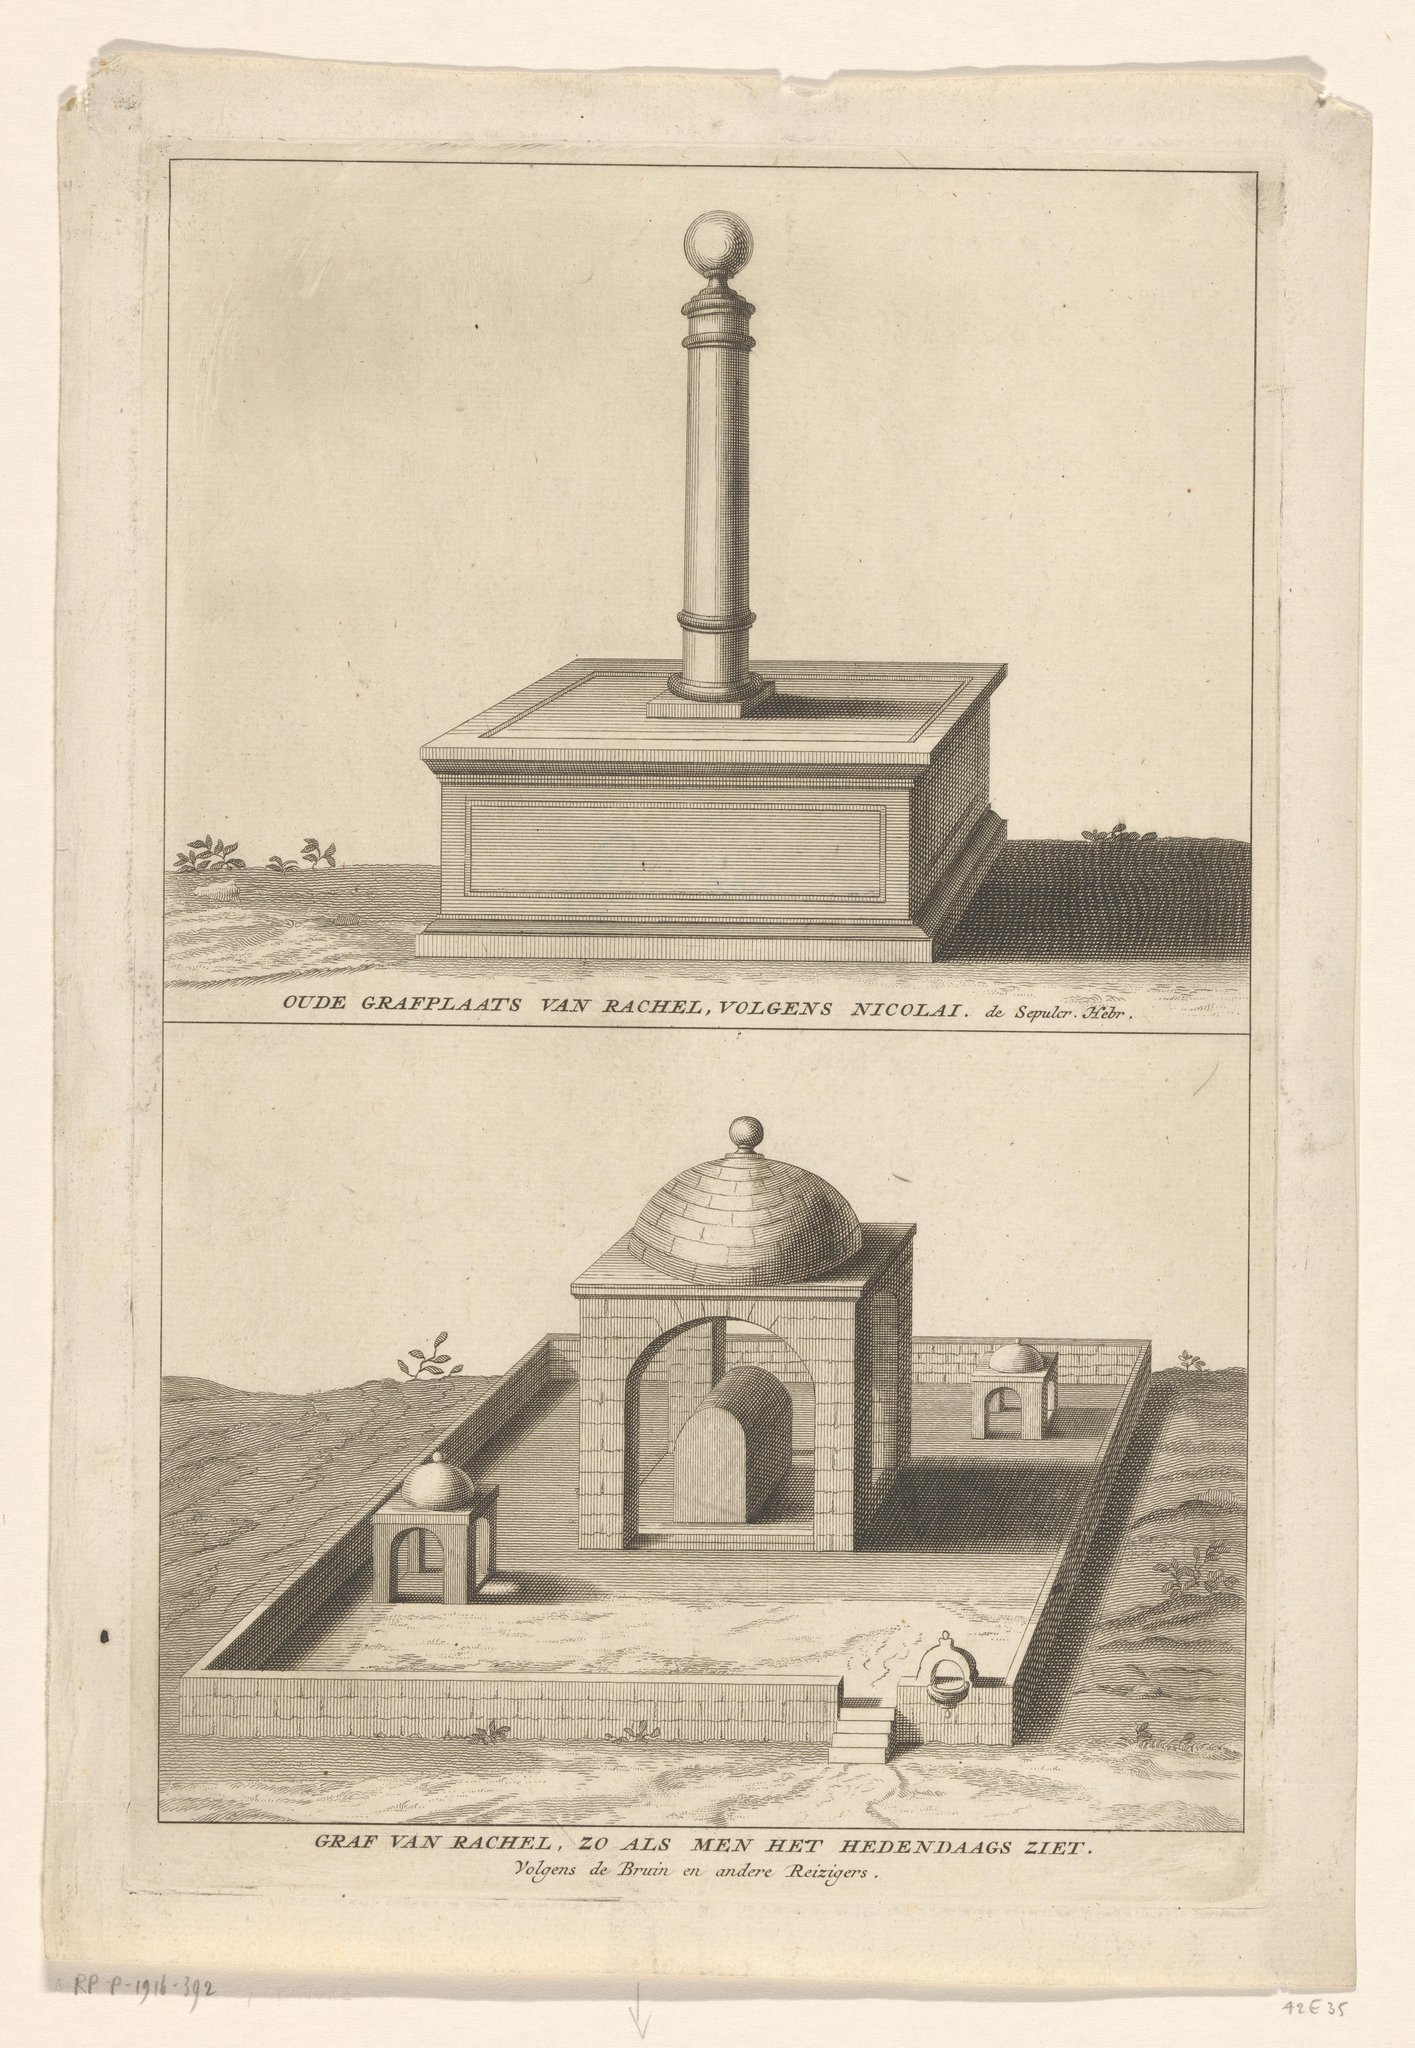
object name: book illustration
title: Oude grafplaats van Rachel, volgens Nicolai. de Sepuler. Hebr. / Graf van Rachel, zo als men het hedendaags ziet. Volgens de Bruin en andere Reizigers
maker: Anonymous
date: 1727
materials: paper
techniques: engraving, etching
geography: netherlands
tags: historical grave forms, female persons from the old testament (not in biblical context), grave-building, monumental tomb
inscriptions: collector's mark: Lugt 2228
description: Gebruikt als illustratie in: Het algemeen groot historisch, oordeelkundig, chronologisch, geografisch, en letterlyk naam- en woord-boek, van den gantschen H. Bijbel. Dienende tot de gedenk-stukken der Jooden en andere oudheden, ter opheldering der H. Schrift . Nu in't Nederduitsch overgezet, merkelyk vermeerdert, en met aanmerkingen verrykt, door Mattheus Gargon.' and it's additons: 'Byvogzel tot het algemeen groot . Naam- en woord-boek . En nu in zuiver Nederduitsch overgezet, merkelyk vermeerdert, en metv aanmerkingen verrykt, door Jakob van Ostade en Arn. Henr. Westerhovius.', by Augustines Calmet, published in Leiden, Amsterdam, by Samuel Luchtmans, R. & J. Wetstein en Smith 1725-1731. Deel II (1727), p. 218/219. De prenten in dit werk zijn vervaardigd door: A. de Putter, F. van Bleyswyk, M. Pool, Ph. van Gunst, e.a.